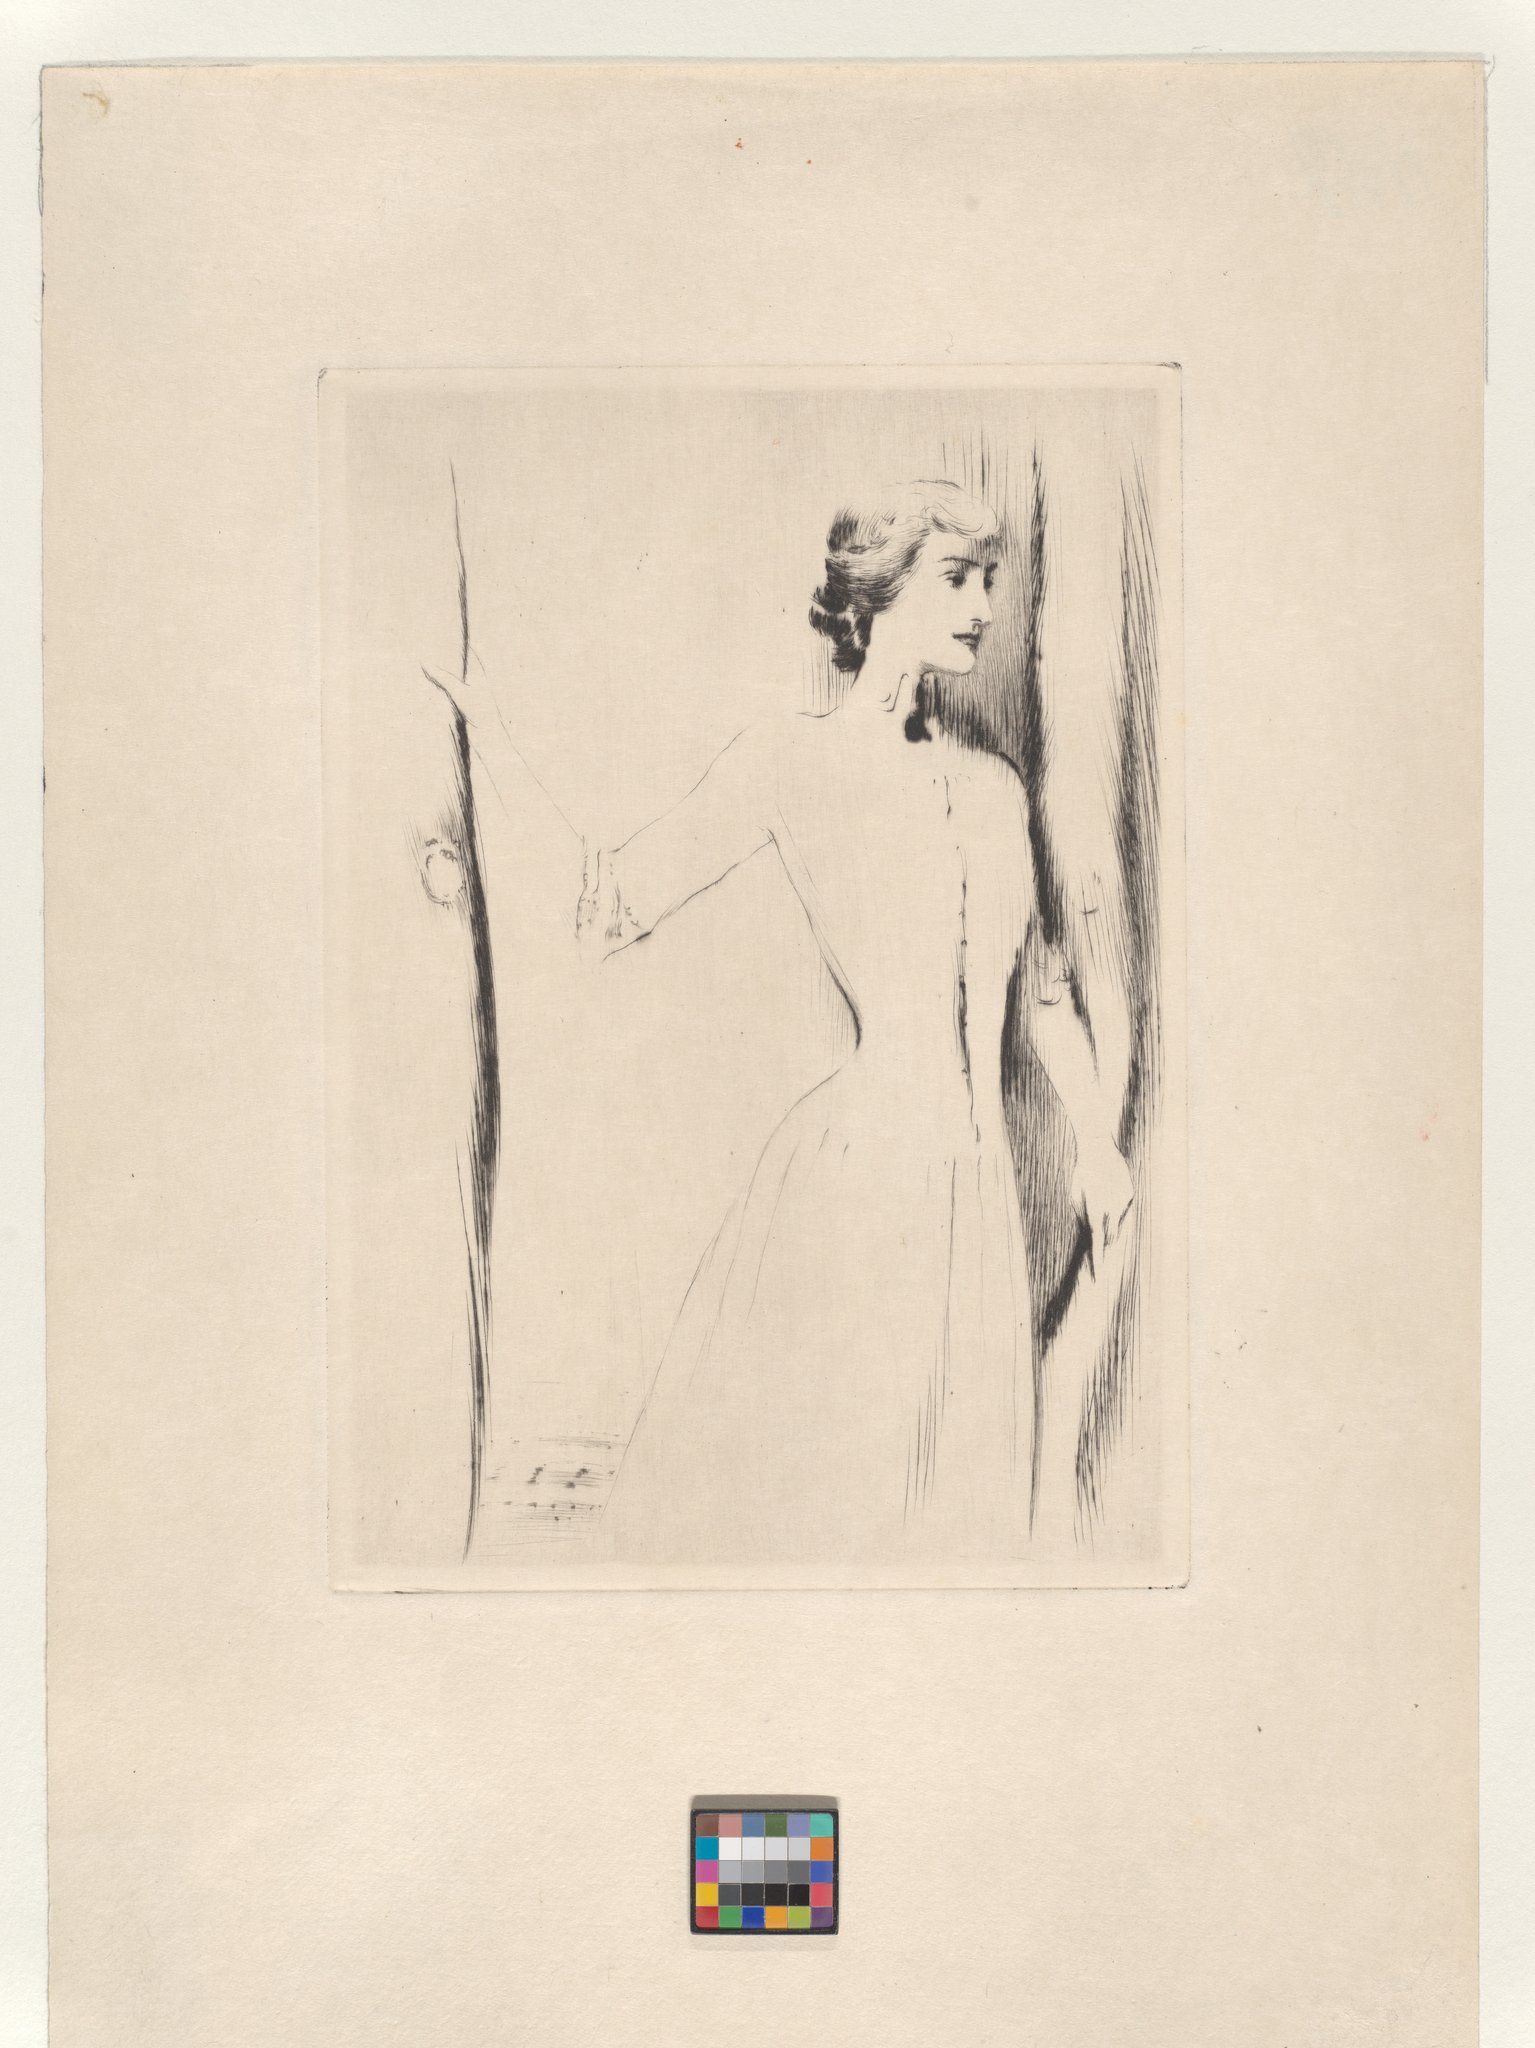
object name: print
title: The Curtain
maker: fernand khnopff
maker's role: artist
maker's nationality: belgian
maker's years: 1858-1921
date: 1904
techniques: drypoint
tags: women